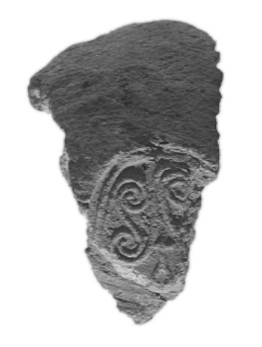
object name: sealing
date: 2030-1640 BCE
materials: clay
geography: egypt